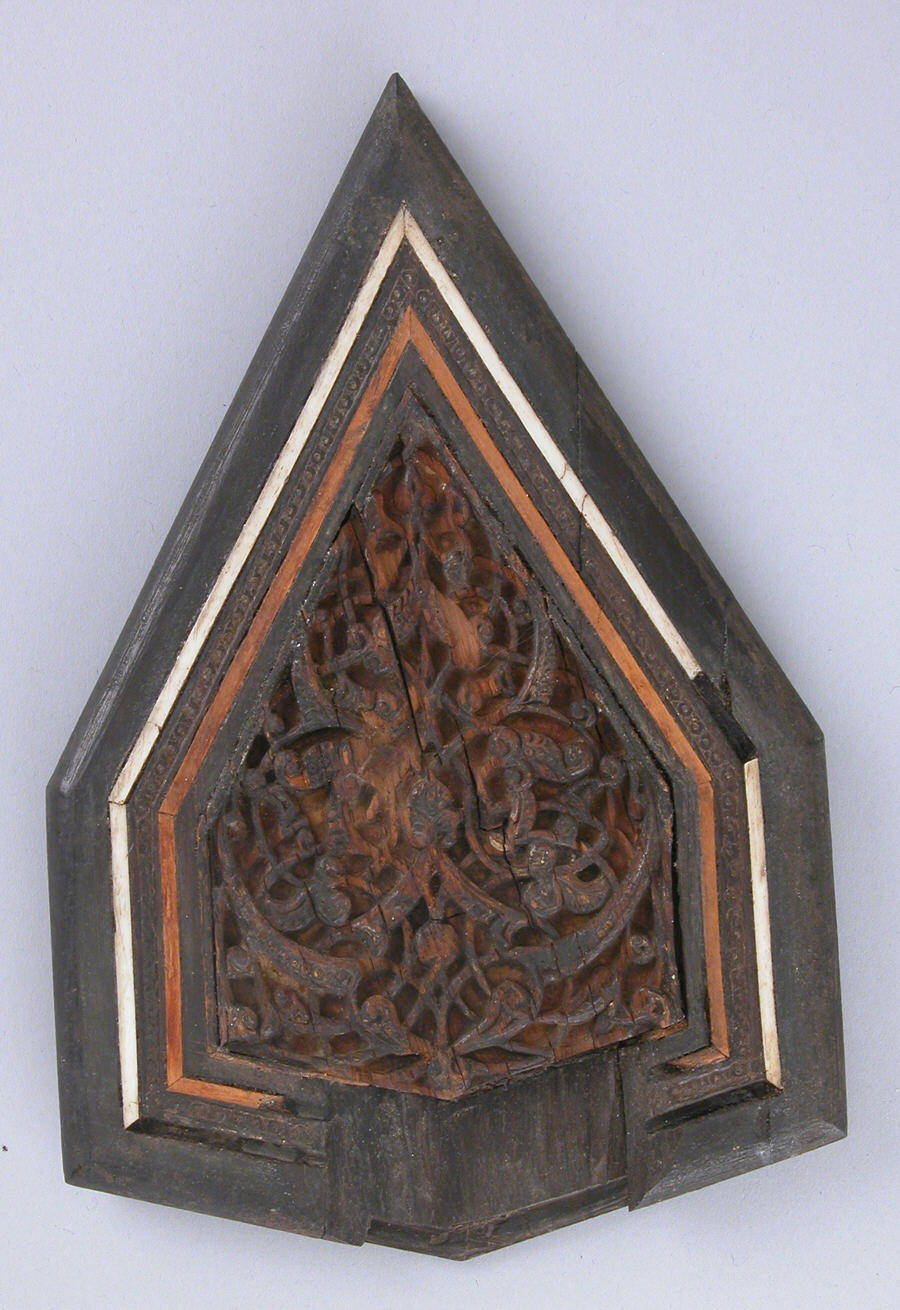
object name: panel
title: Panel from a Minbar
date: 1201-1400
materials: ivory, paint, wood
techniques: carving, inlay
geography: egypt